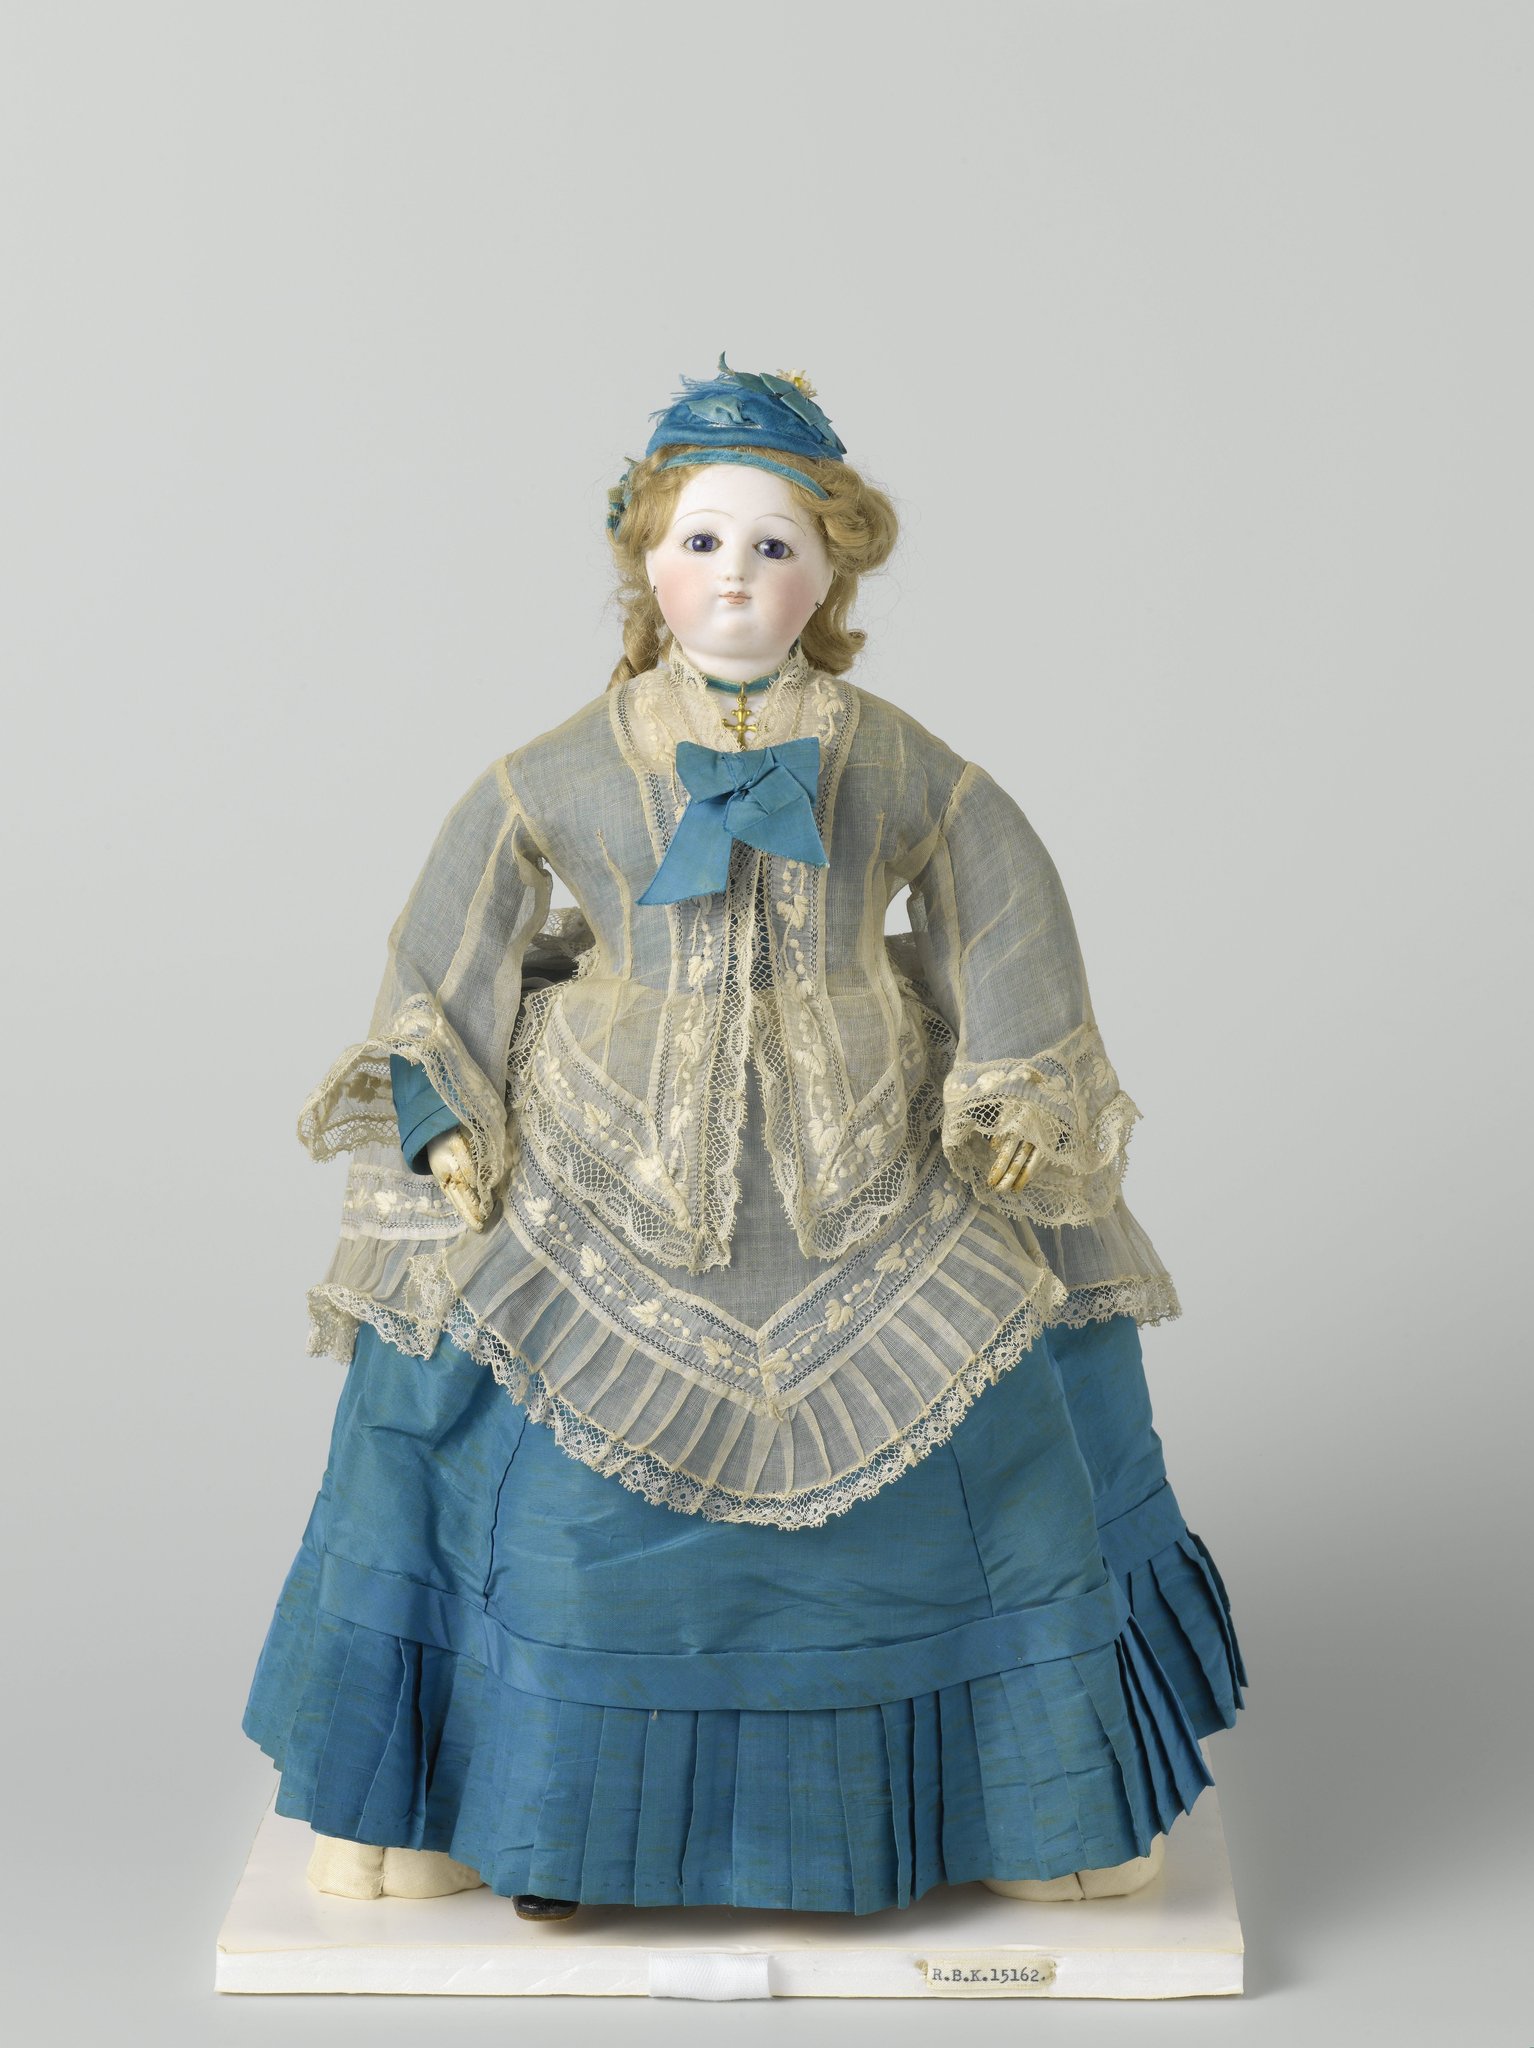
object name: clothing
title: Pop met lang blond gekruld haar en ledematen van wit glacéleer. Gekleed in blauw zijden costuum met wit batisten lijf en tuniek, met bijbehorende hoed en schoenen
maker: Anonymous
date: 1875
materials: textile, silk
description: Pop met lang blond gekruld haar en ledematen van wit glacéleer. Gekleed in een blauw zijden kostuum. Model: glad lijf, gladde aflopende schouders waaraan gladde mouwen, wijd uitstaande sleeprok, van voren glad in de taille, van achter twee diepe plooien, zodat een crinoline als opvulling kan dienen die van voren afgeplat. Driekwart lange overjapon van batist met wijd uitlopende mouwen, van voren puntig, van achter in twee bogen eindigend, diep ingesneden schootslippen. Hoed van wit stro en blauw fluweel, struisveer en strik en bloempjes. Goudleren schoenen met gesp en driekwart hak. Set ondergoed.